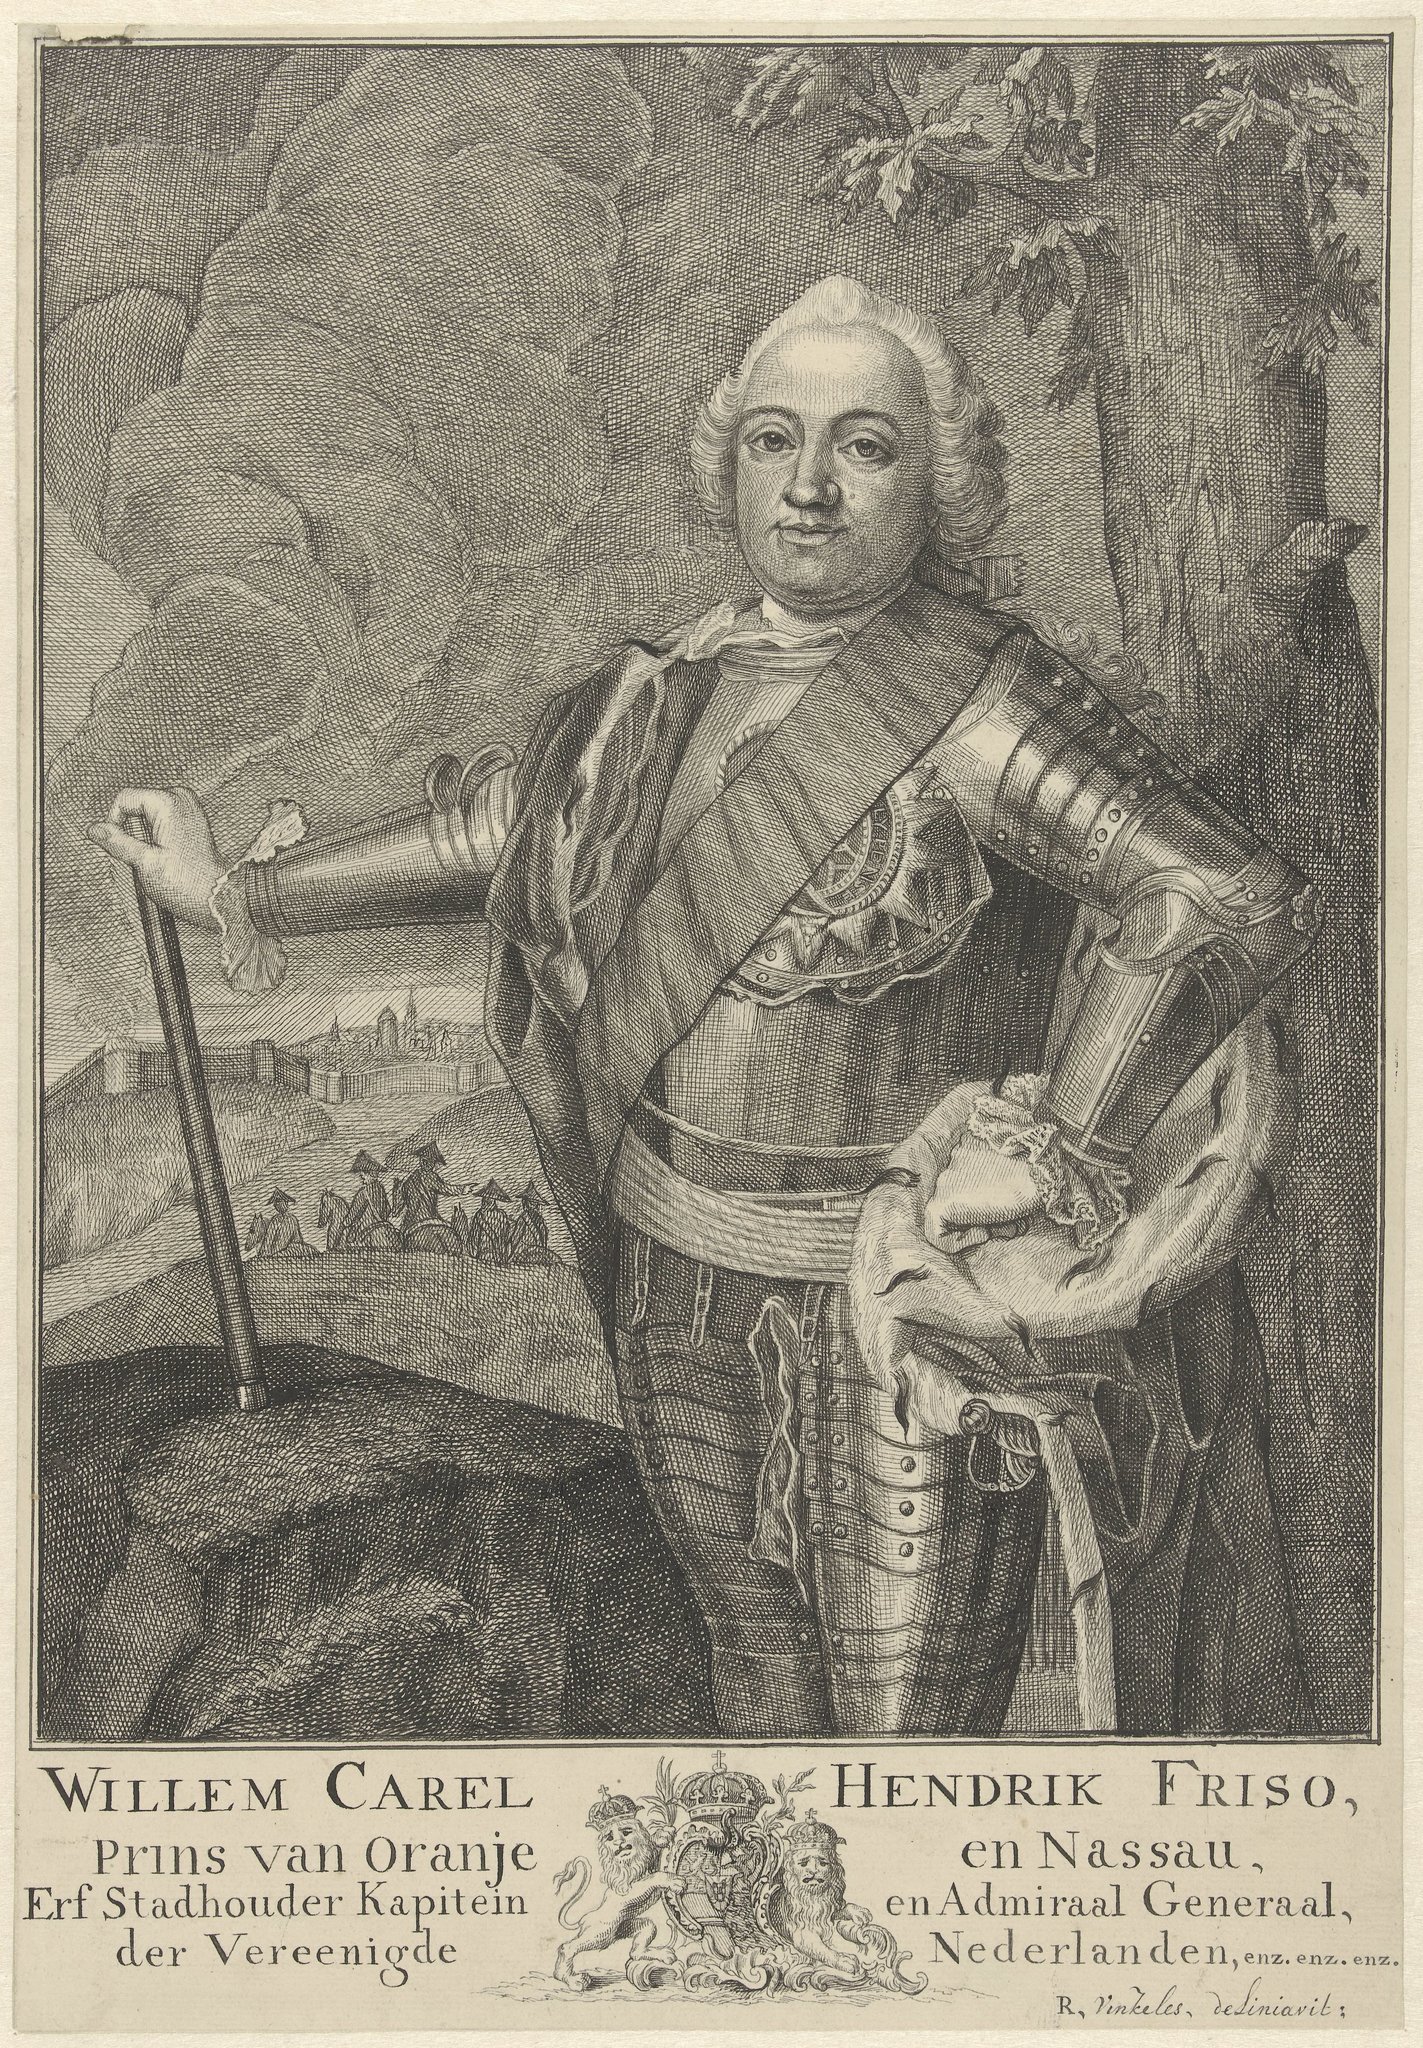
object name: drawing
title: Portret van Willem IV, prins van Oranje Nassau, in wapenrusting met maarschalksstaf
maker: Anonymous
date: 1751-1866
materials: ink, paper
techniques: pen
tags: the hague, willem iv (prins van oranje-nassau), historical persons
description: Portret van Willem IV. Opschrift: Willem Carel Hendrik Friso, / Prins van Oranje en Nassau, / Erf Stadhouder Kapitein en Admiraal Generaal, / der Vereenigde Nederlanden, enz.enz.enz. / R, Vinkeles deliniavit.